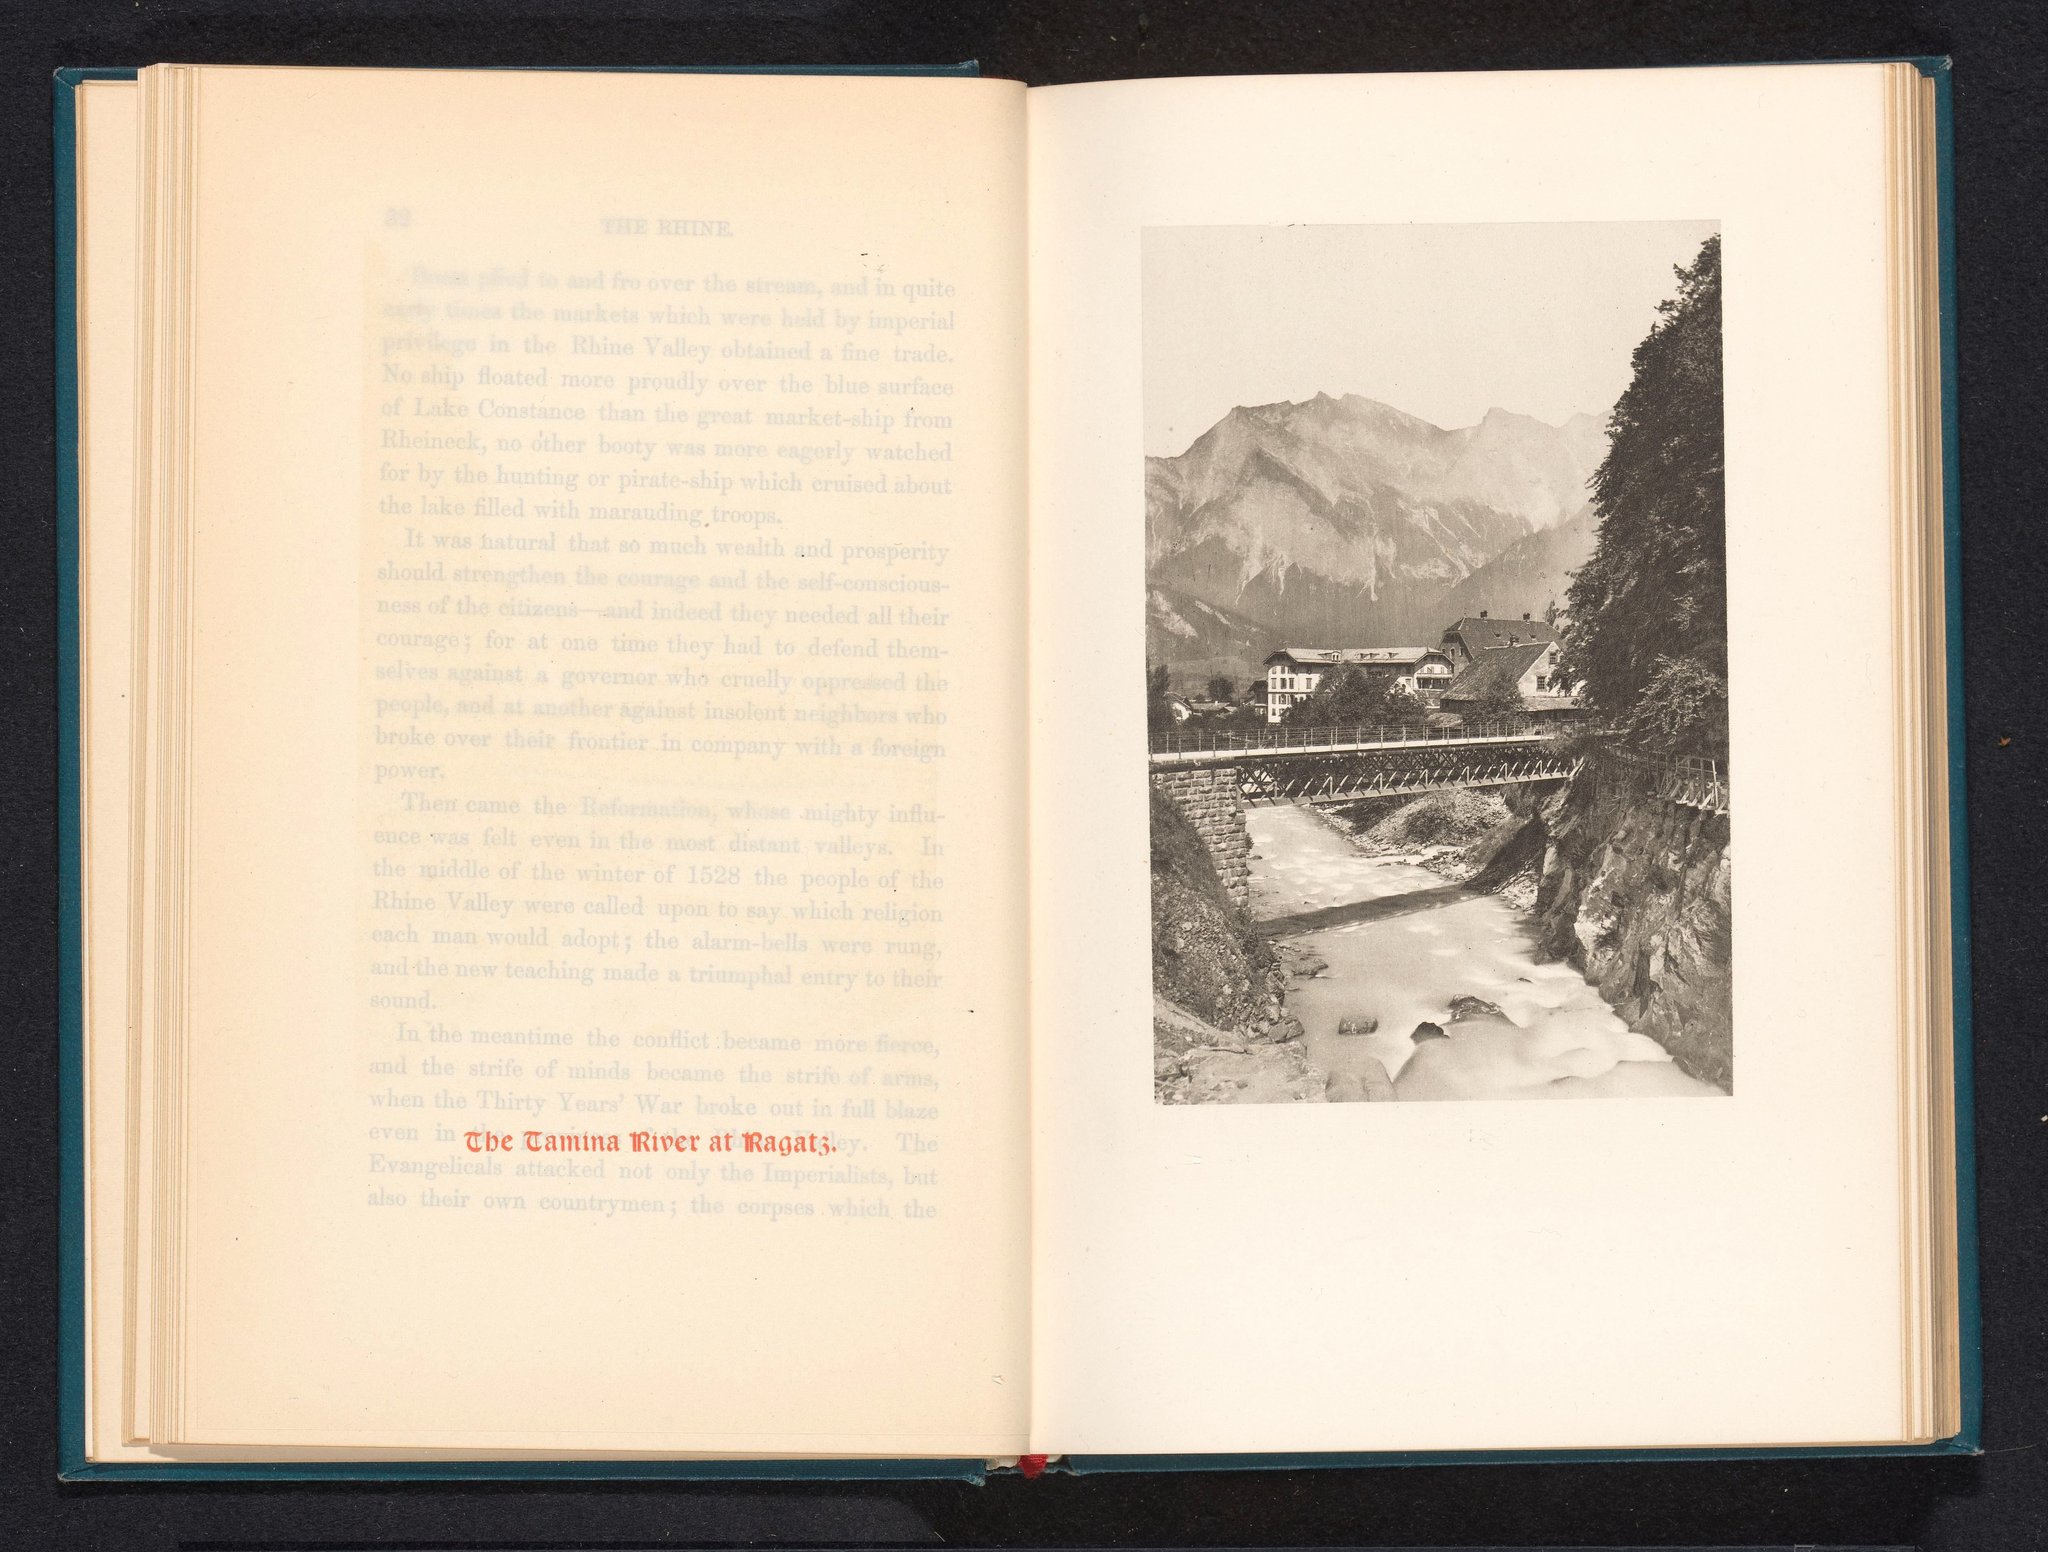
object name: page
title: Brug over de Tamina te Bad Ragaz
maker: Anonymous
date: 1889-1899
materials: paper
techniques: photoaquatint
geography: bad ragaz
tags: bridge in village across river, canal, etc.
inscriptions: title: ‘The Tamina River at Ragatz.’